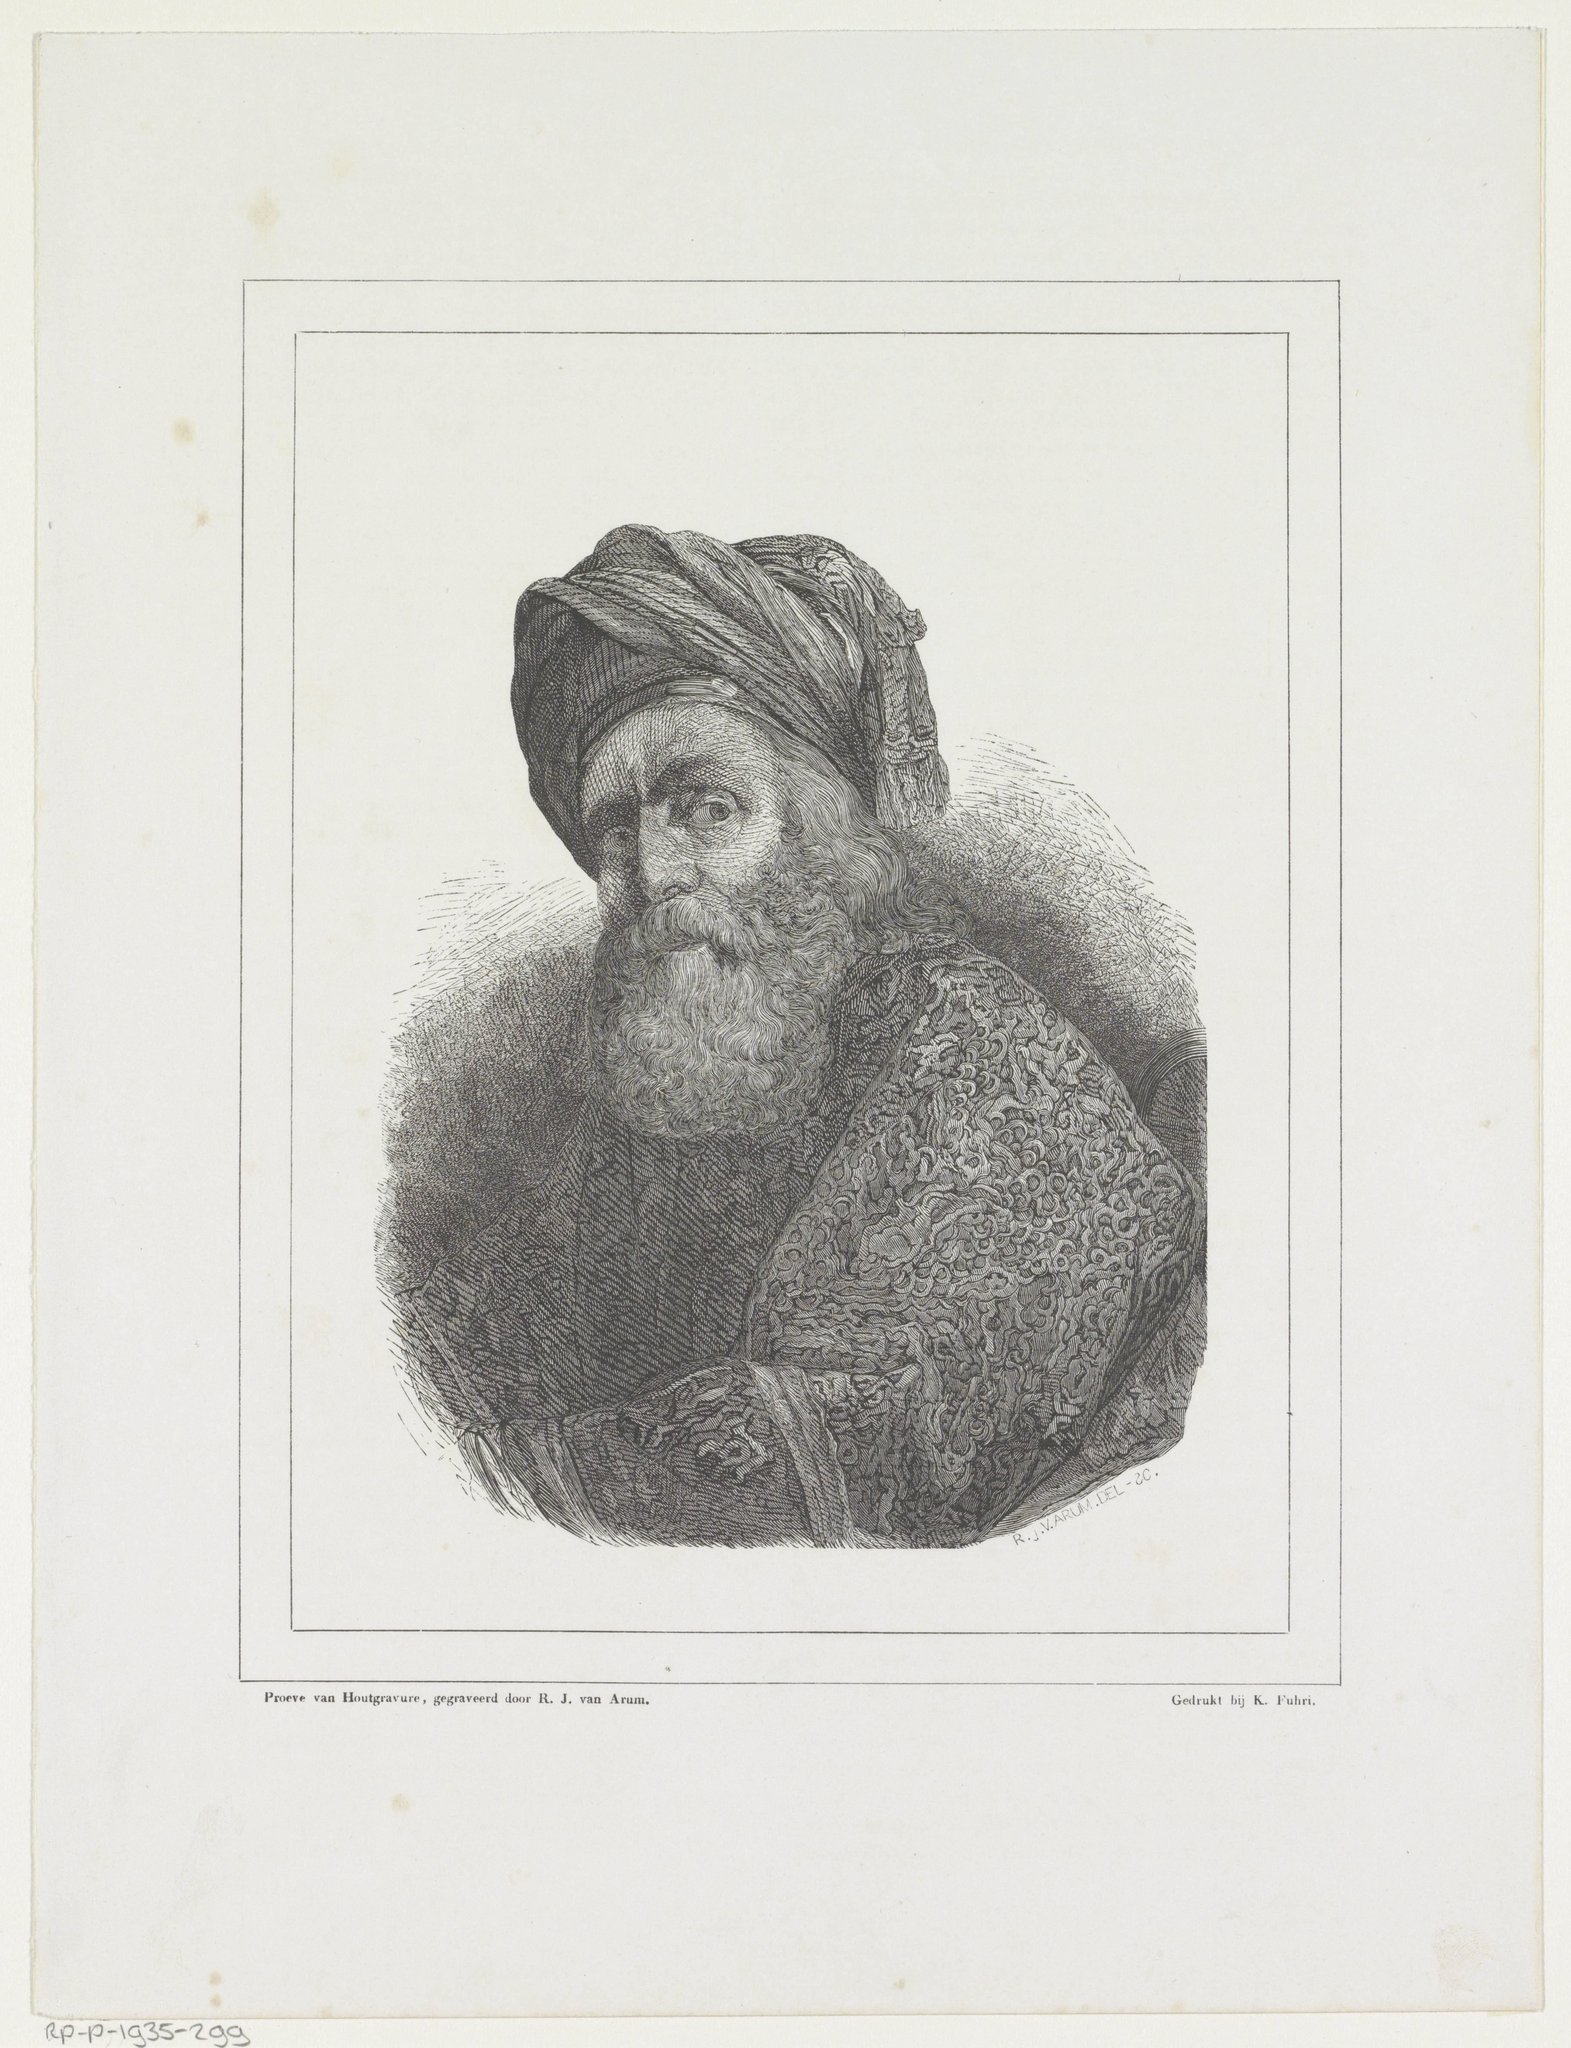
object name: book illustration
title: Oude man met een tulband en een baard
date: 1824-1858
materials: paper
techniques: engraving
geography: amsterdam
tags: head-gear: turban, beard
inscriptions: collector's mark: Lugt 2228